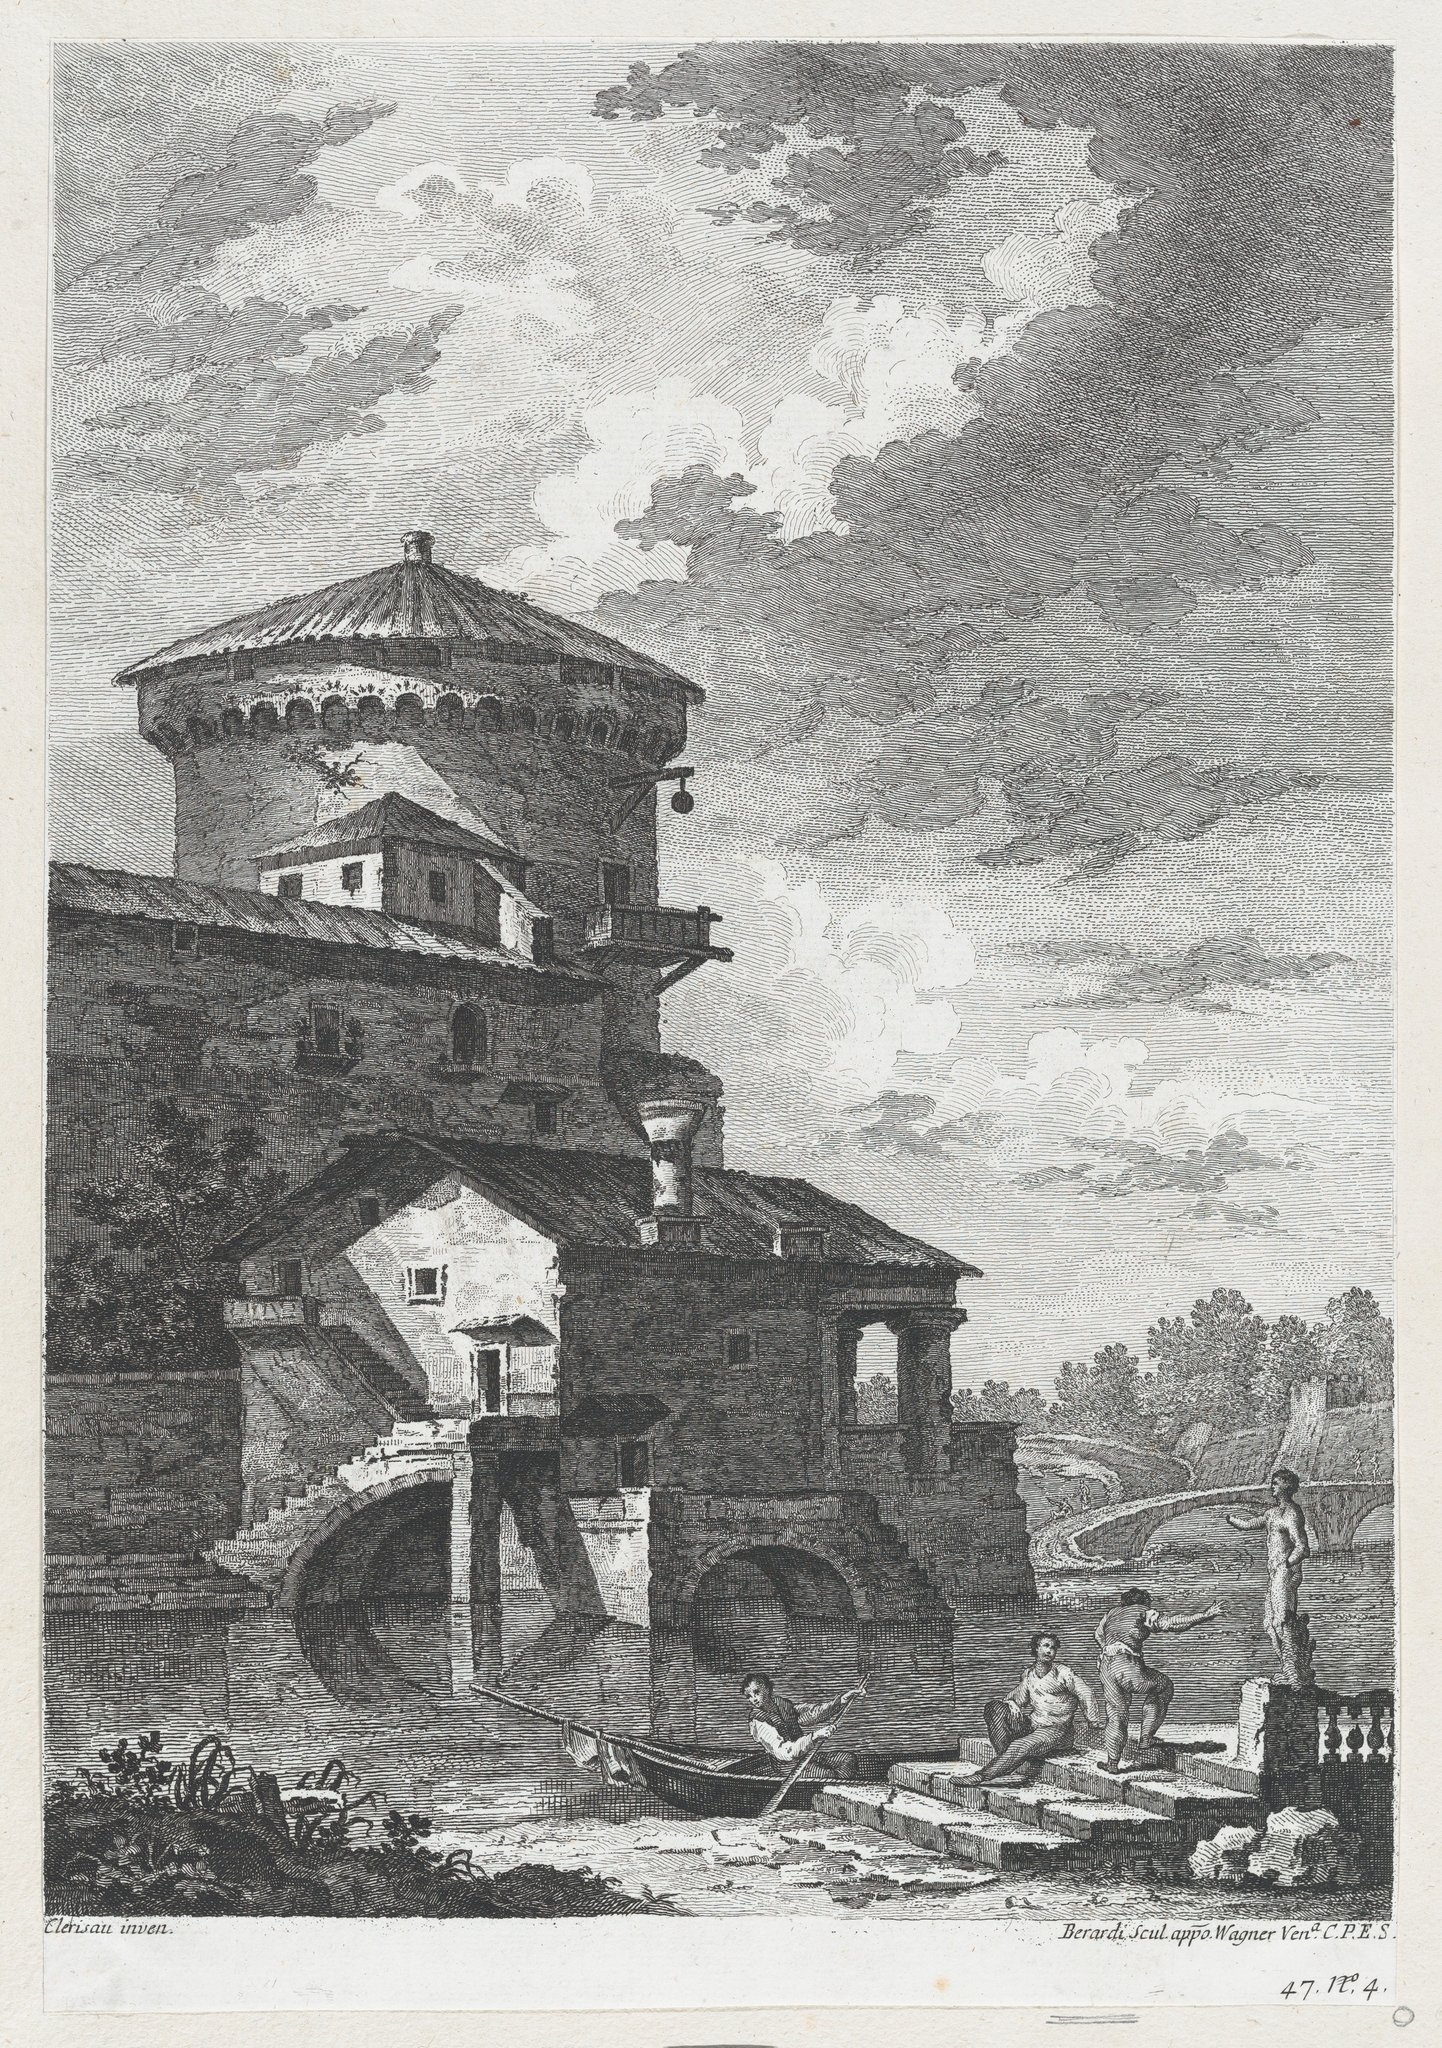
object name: print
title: River Scene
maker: fabio berardi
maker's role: artist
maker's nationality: italian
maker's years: 1728-1788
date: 1750-1770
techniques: etching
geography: venice